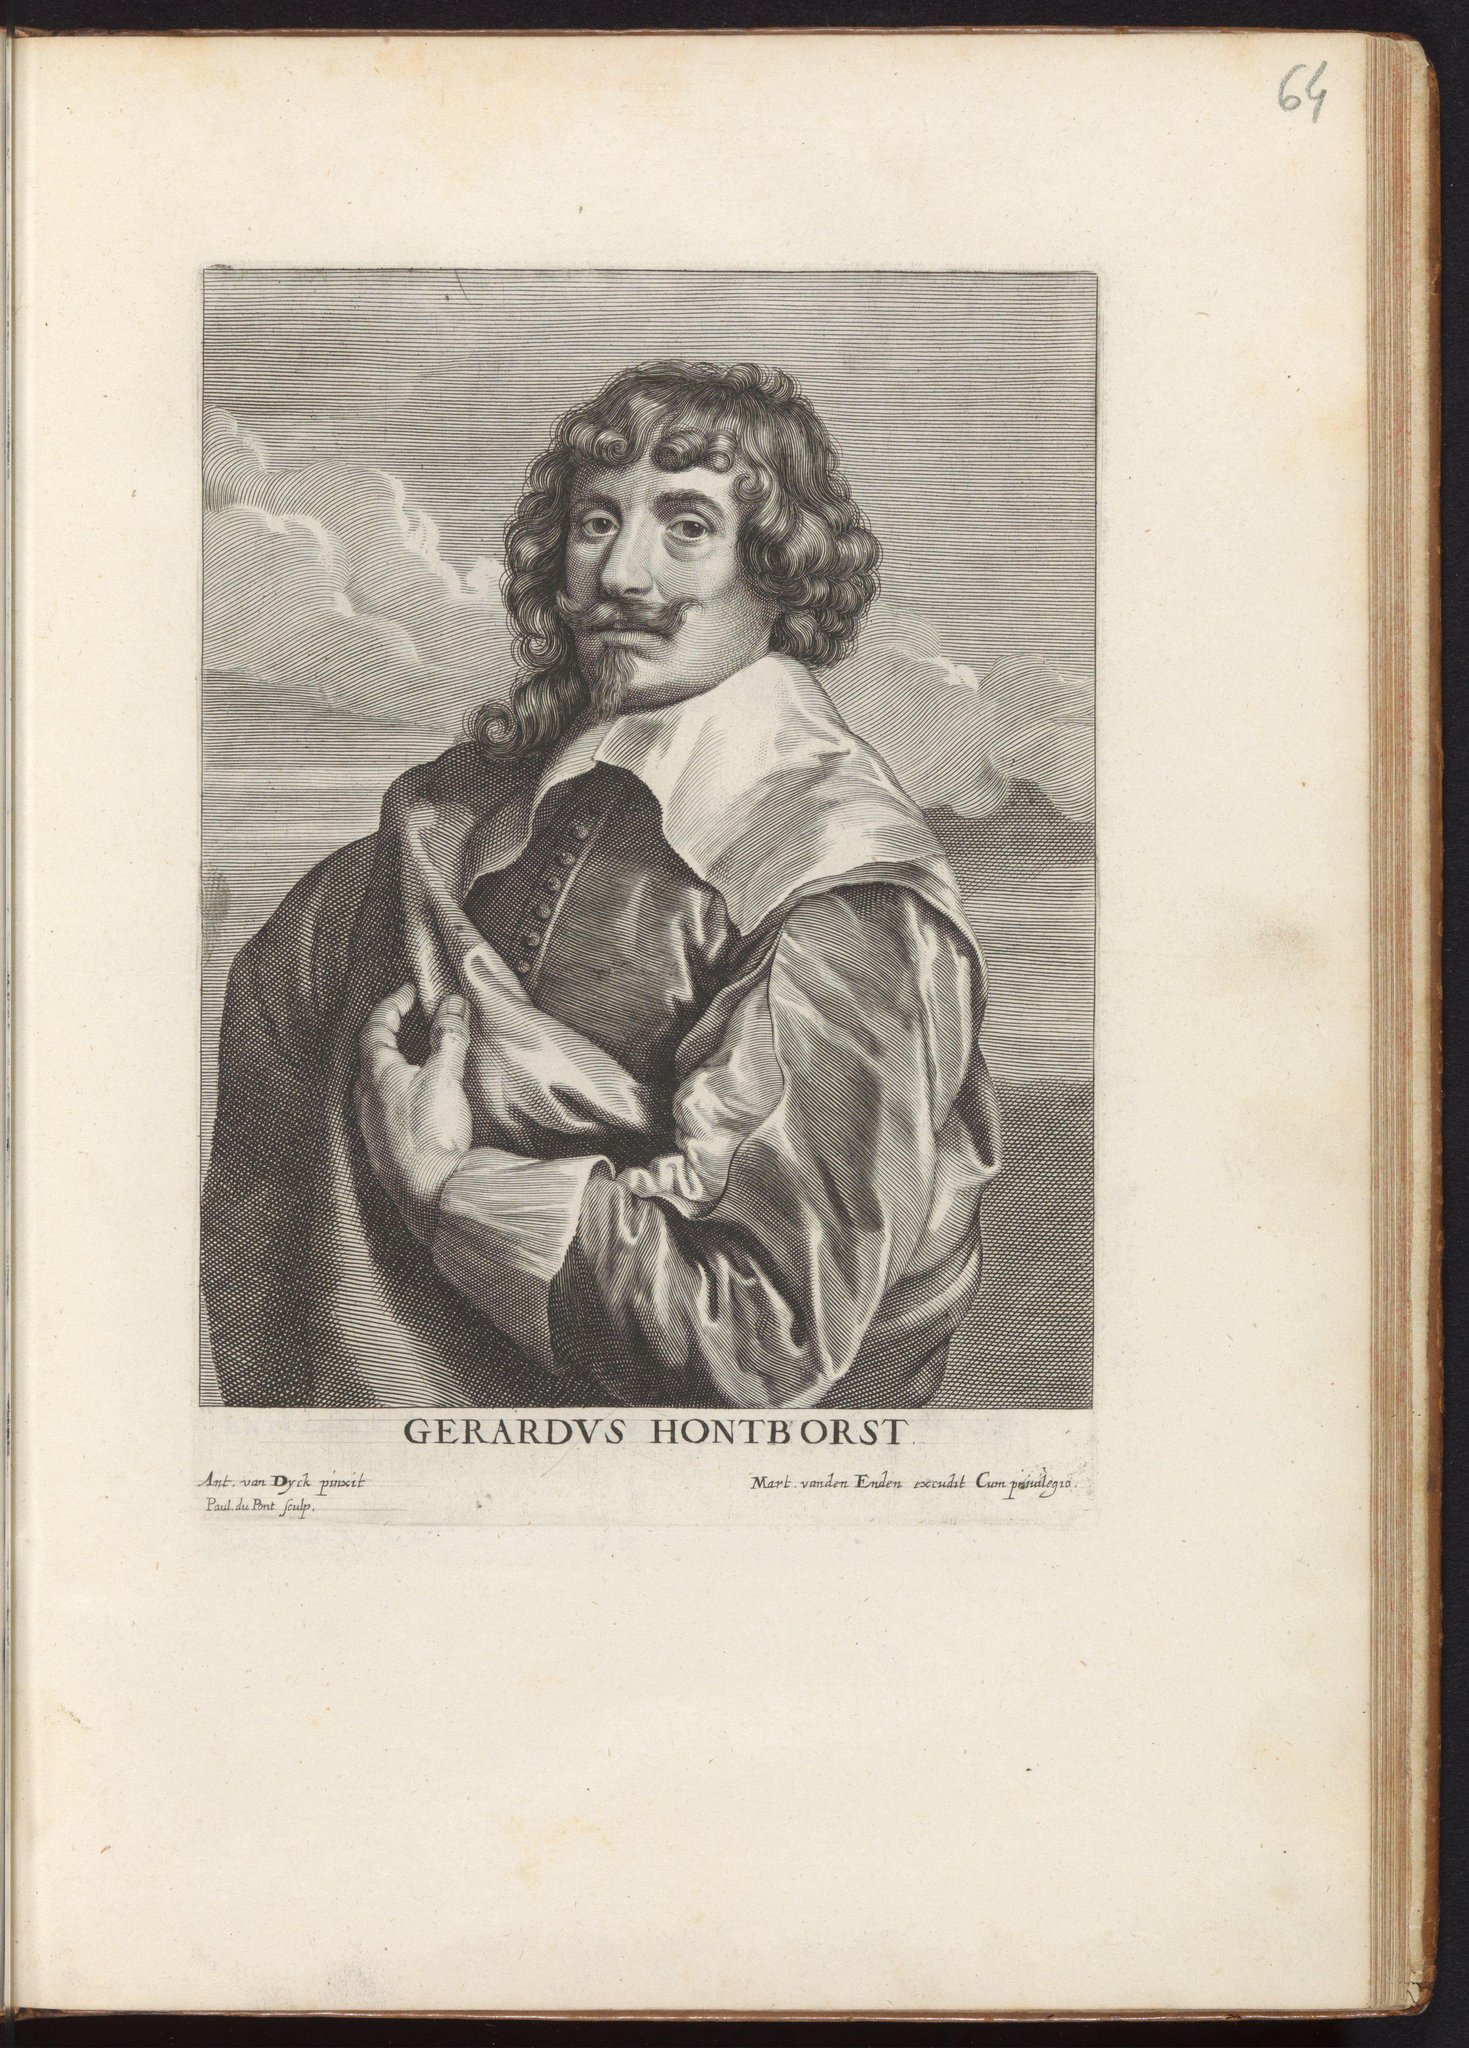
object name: album leaf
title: Icones Principum Vivorum Doctorum Pictorum Chalcographorum Statuariorum nec non Amatorum Pictoriae Artis Numero Centum ab Antonio van Dyck Pictore ad Vivum Expressae Eiusq: Sumptibus aeri incisae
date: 1630-1641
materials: paper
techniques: engraving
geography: antwerp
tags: utrecht, print maker, draughtsman, gerard van honthorst, portrait, self-portrait of painter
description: Deze prent maakt deel uit van een album.